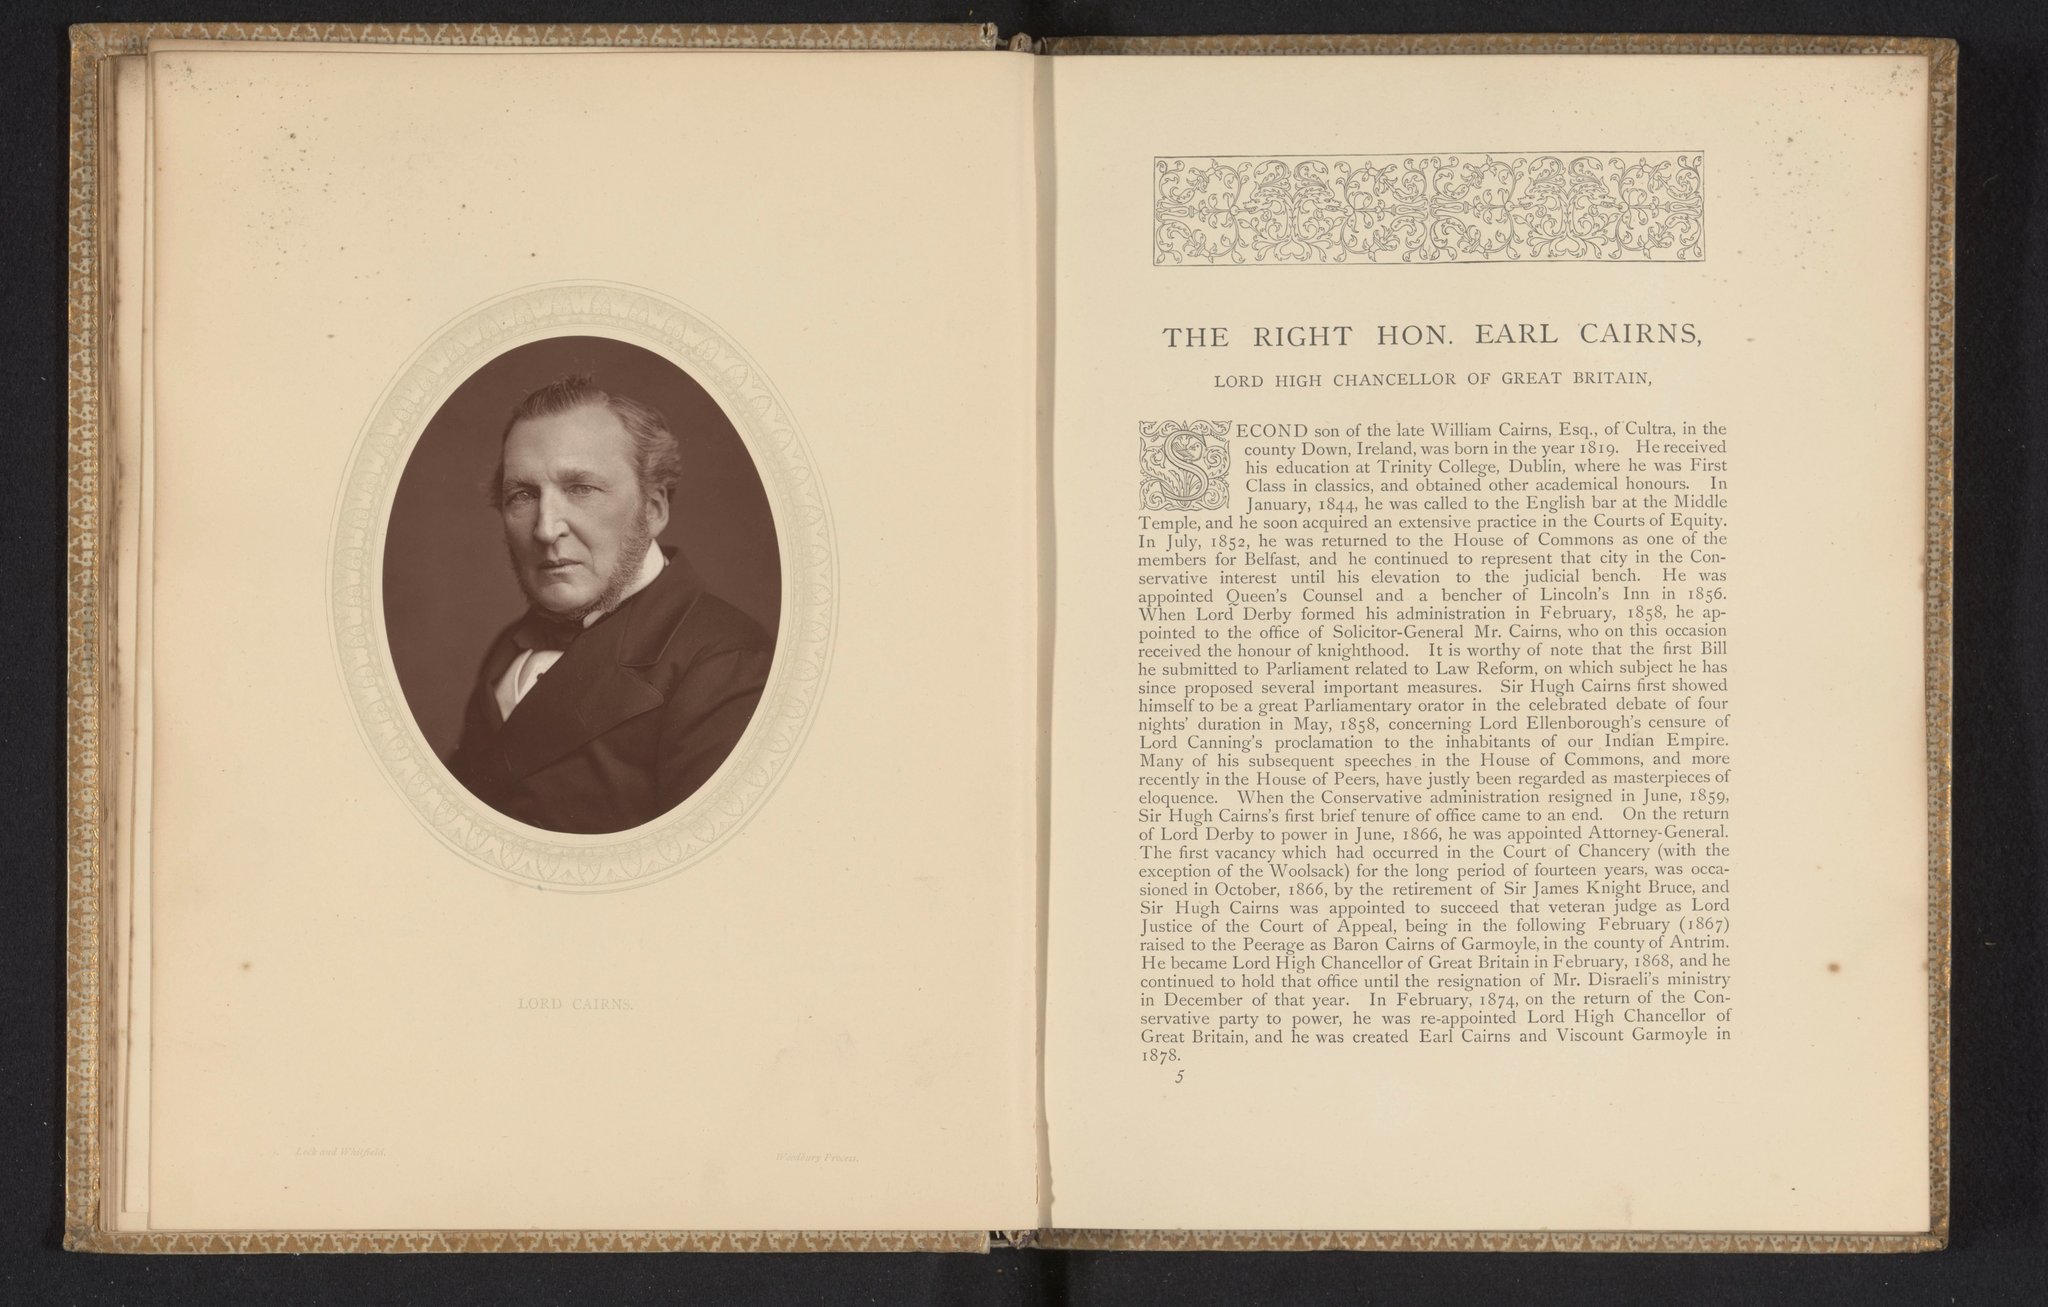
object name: page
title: Lord Cairns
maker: Anonymous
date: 1876-1881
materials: paper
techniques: woodburytype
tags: historical persons (portraits and scenes from the life) (+ (full) bust portrait), politician, e.g. party leader